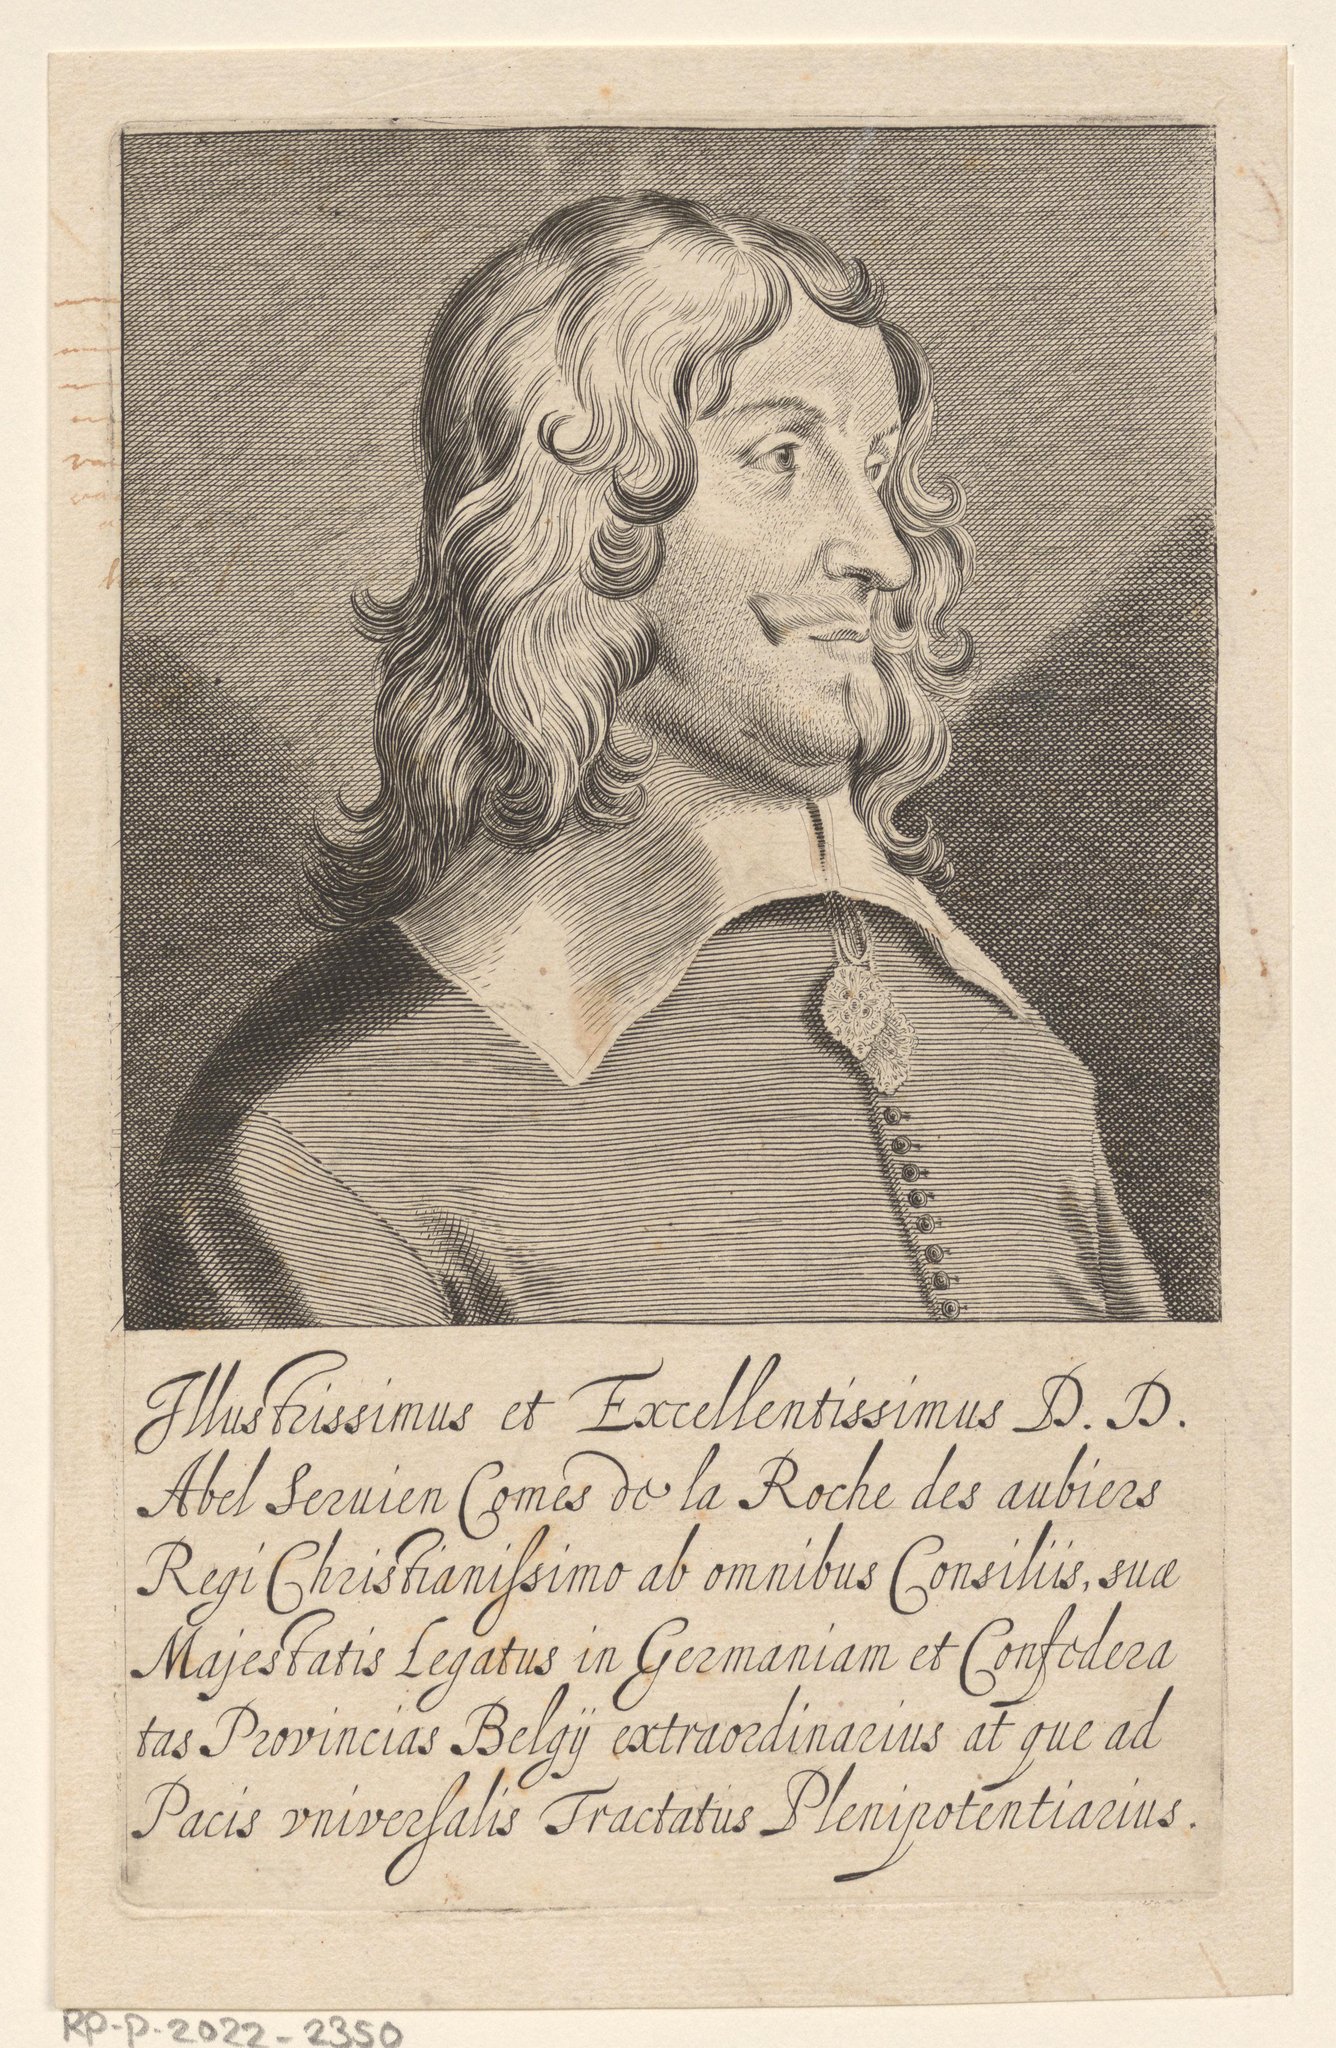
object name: print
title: Portret van Abel de Servien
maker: pieter holsteyn (ii)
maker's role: draughtsman, print maker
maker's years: 1614-1673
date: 1648-1673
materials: paper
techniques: engraving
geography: northern netherlands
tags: historical persons, diplomacy, diplomat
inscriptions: collector's mark: Lugt 240, name: ‘P. Holsteyn’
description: Met zesregelig onderschrift in het Latijn.